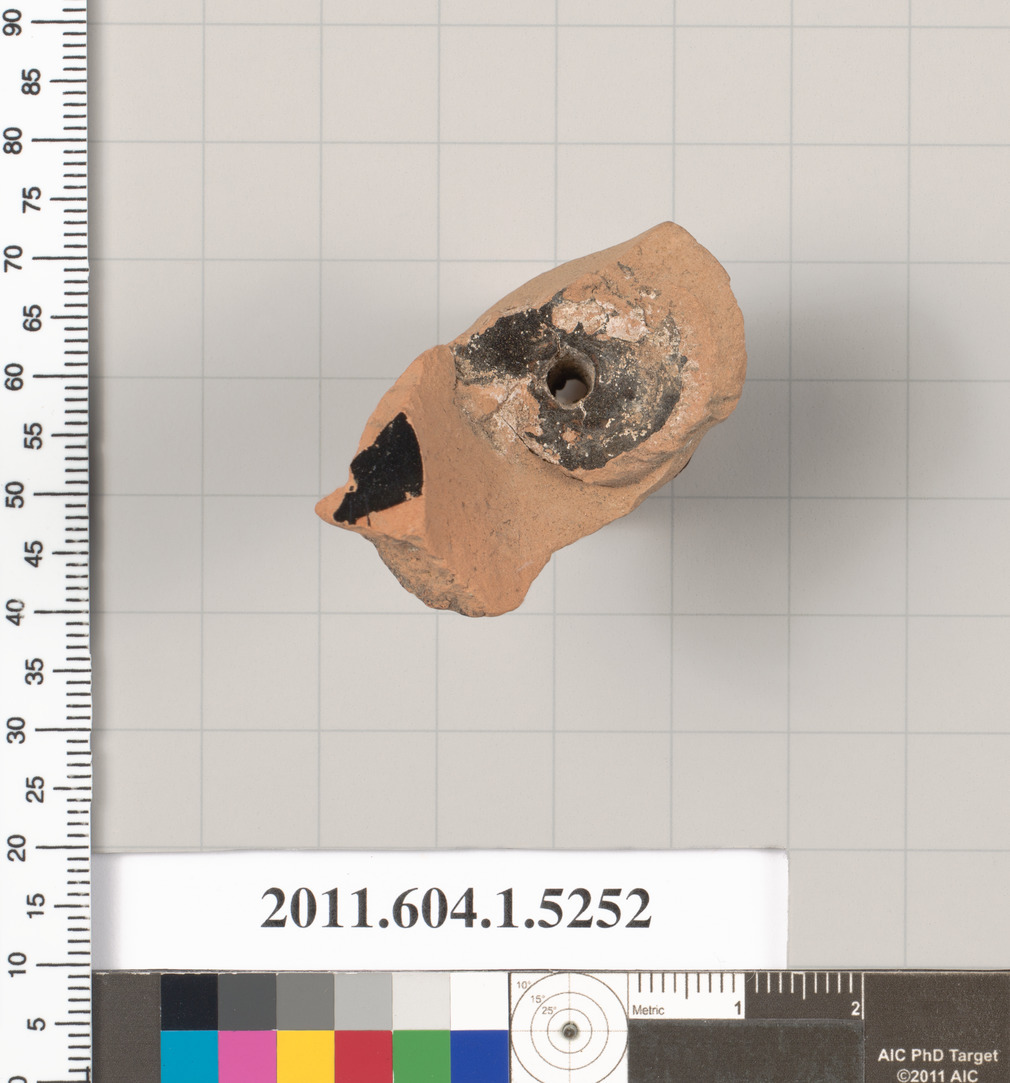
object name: kylix fragment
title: Terracotta fragment of a kylix (drinking cup)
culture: greek, attic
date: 475-451 BCE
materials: terracotta